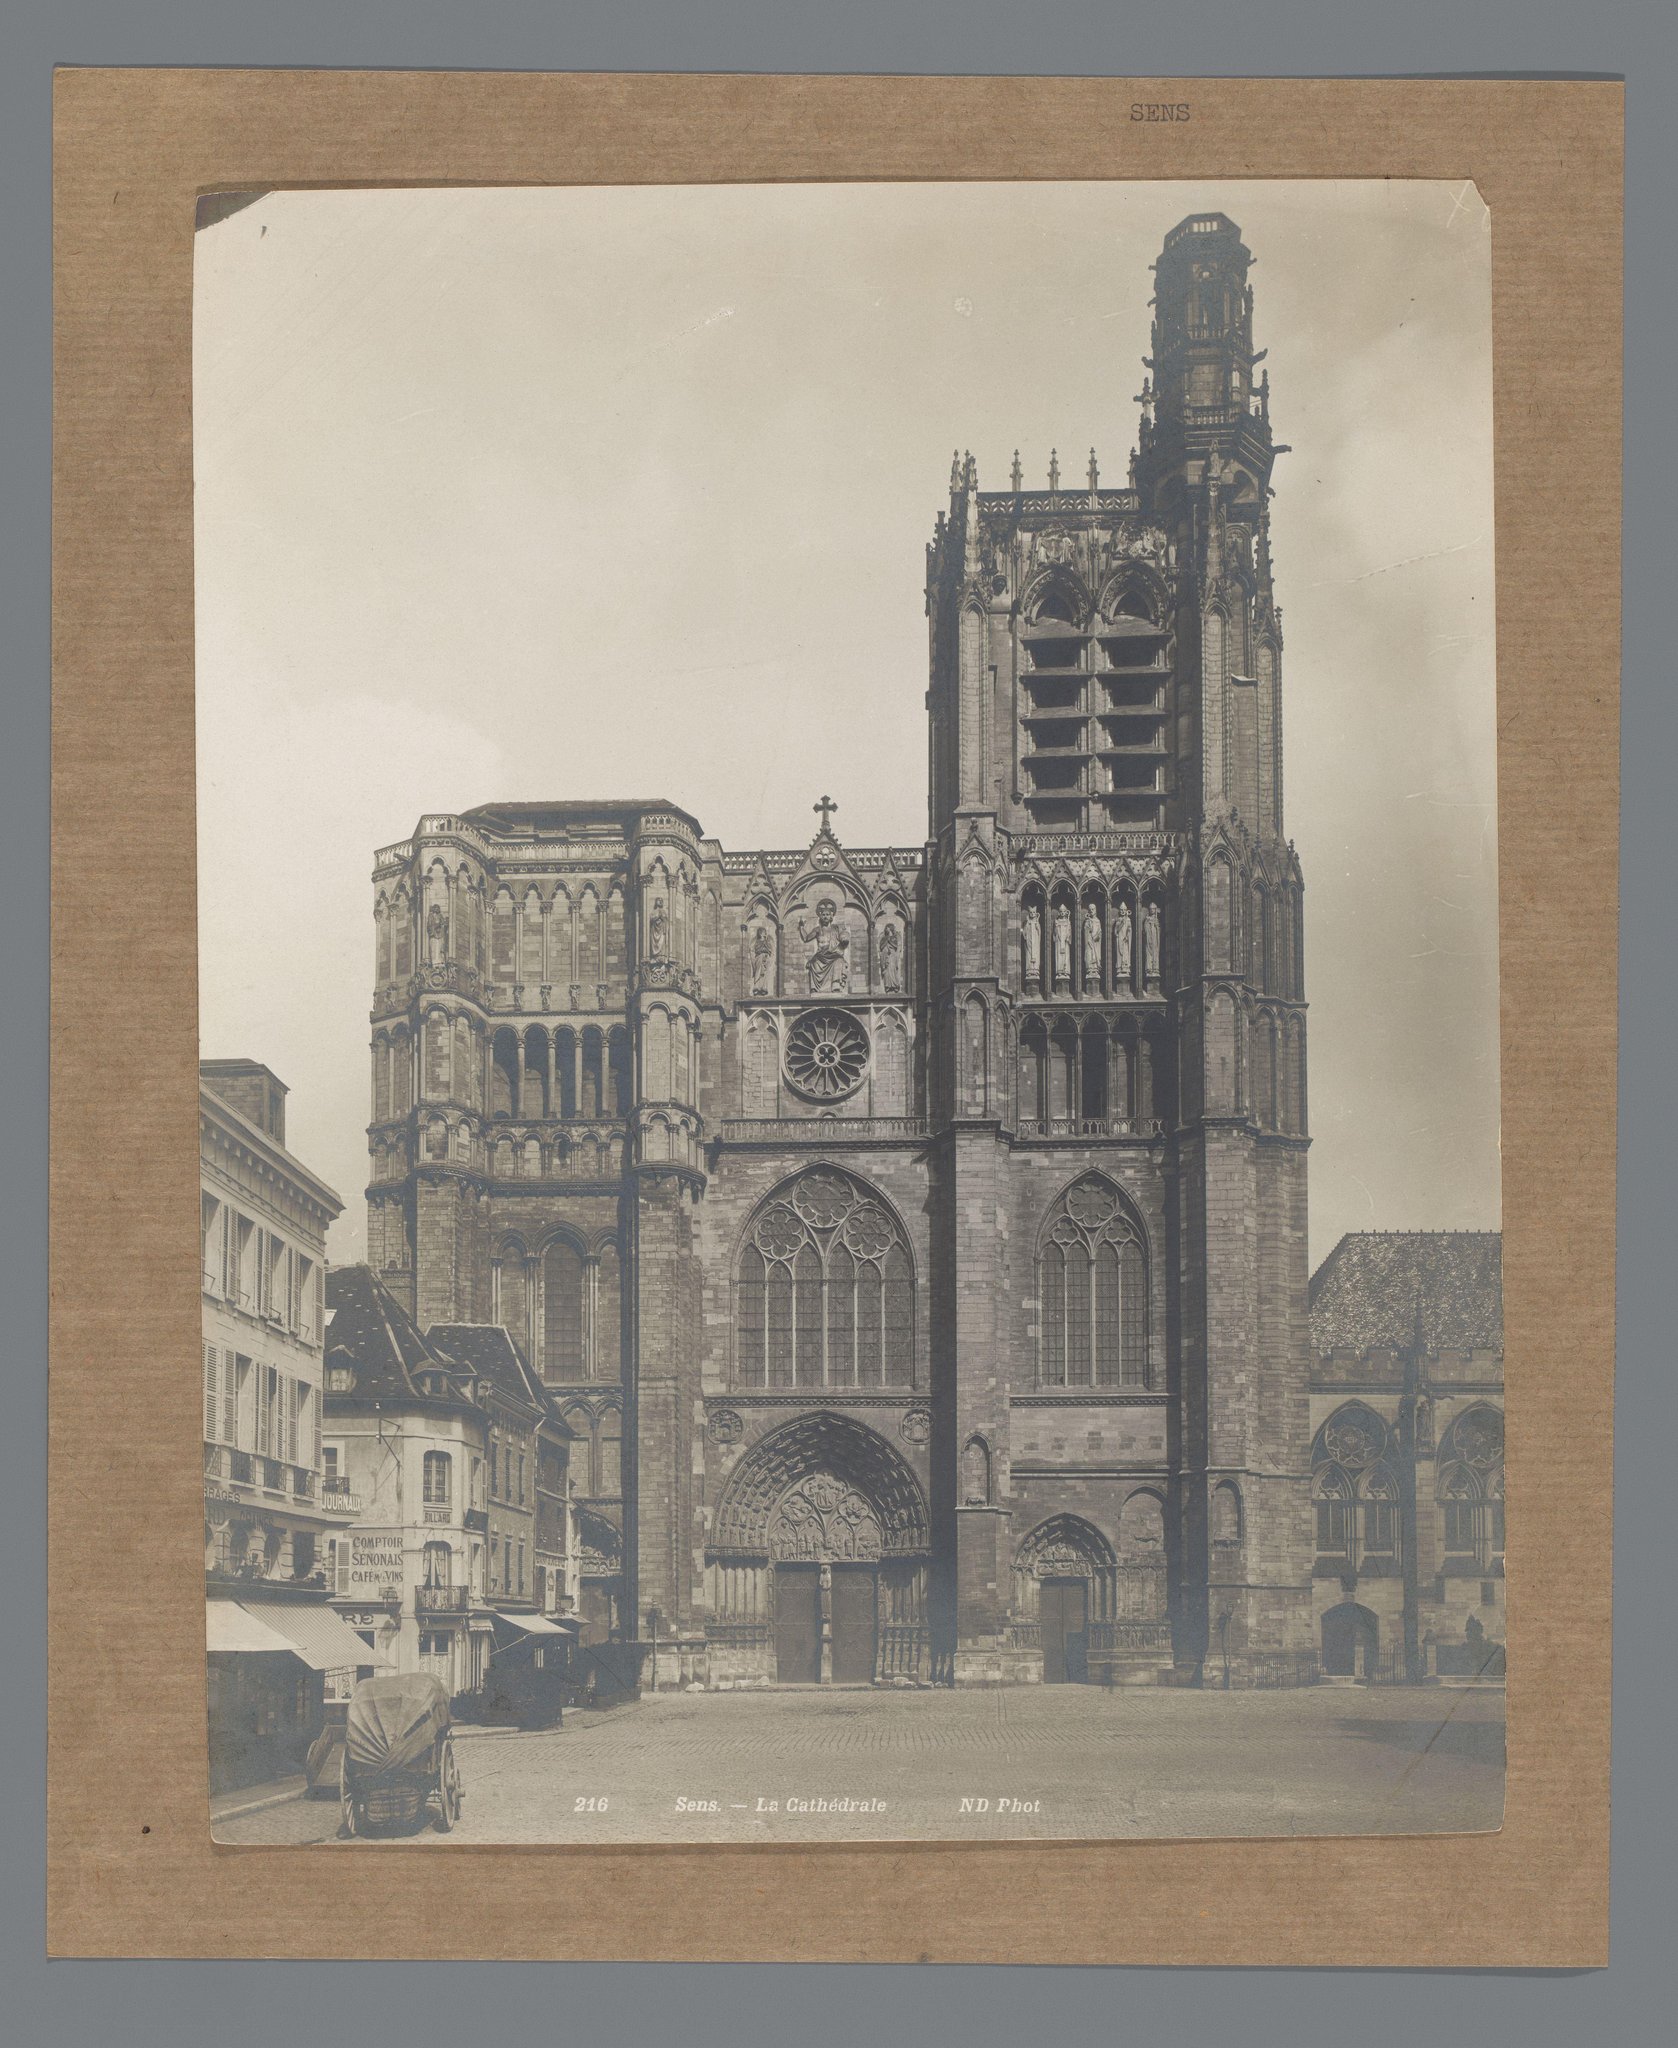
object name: photograph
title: Sens. Cathédrale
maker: Anonymous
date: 1880-1930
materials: photographic support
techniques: gelatin silver print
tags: kathedraal van sens